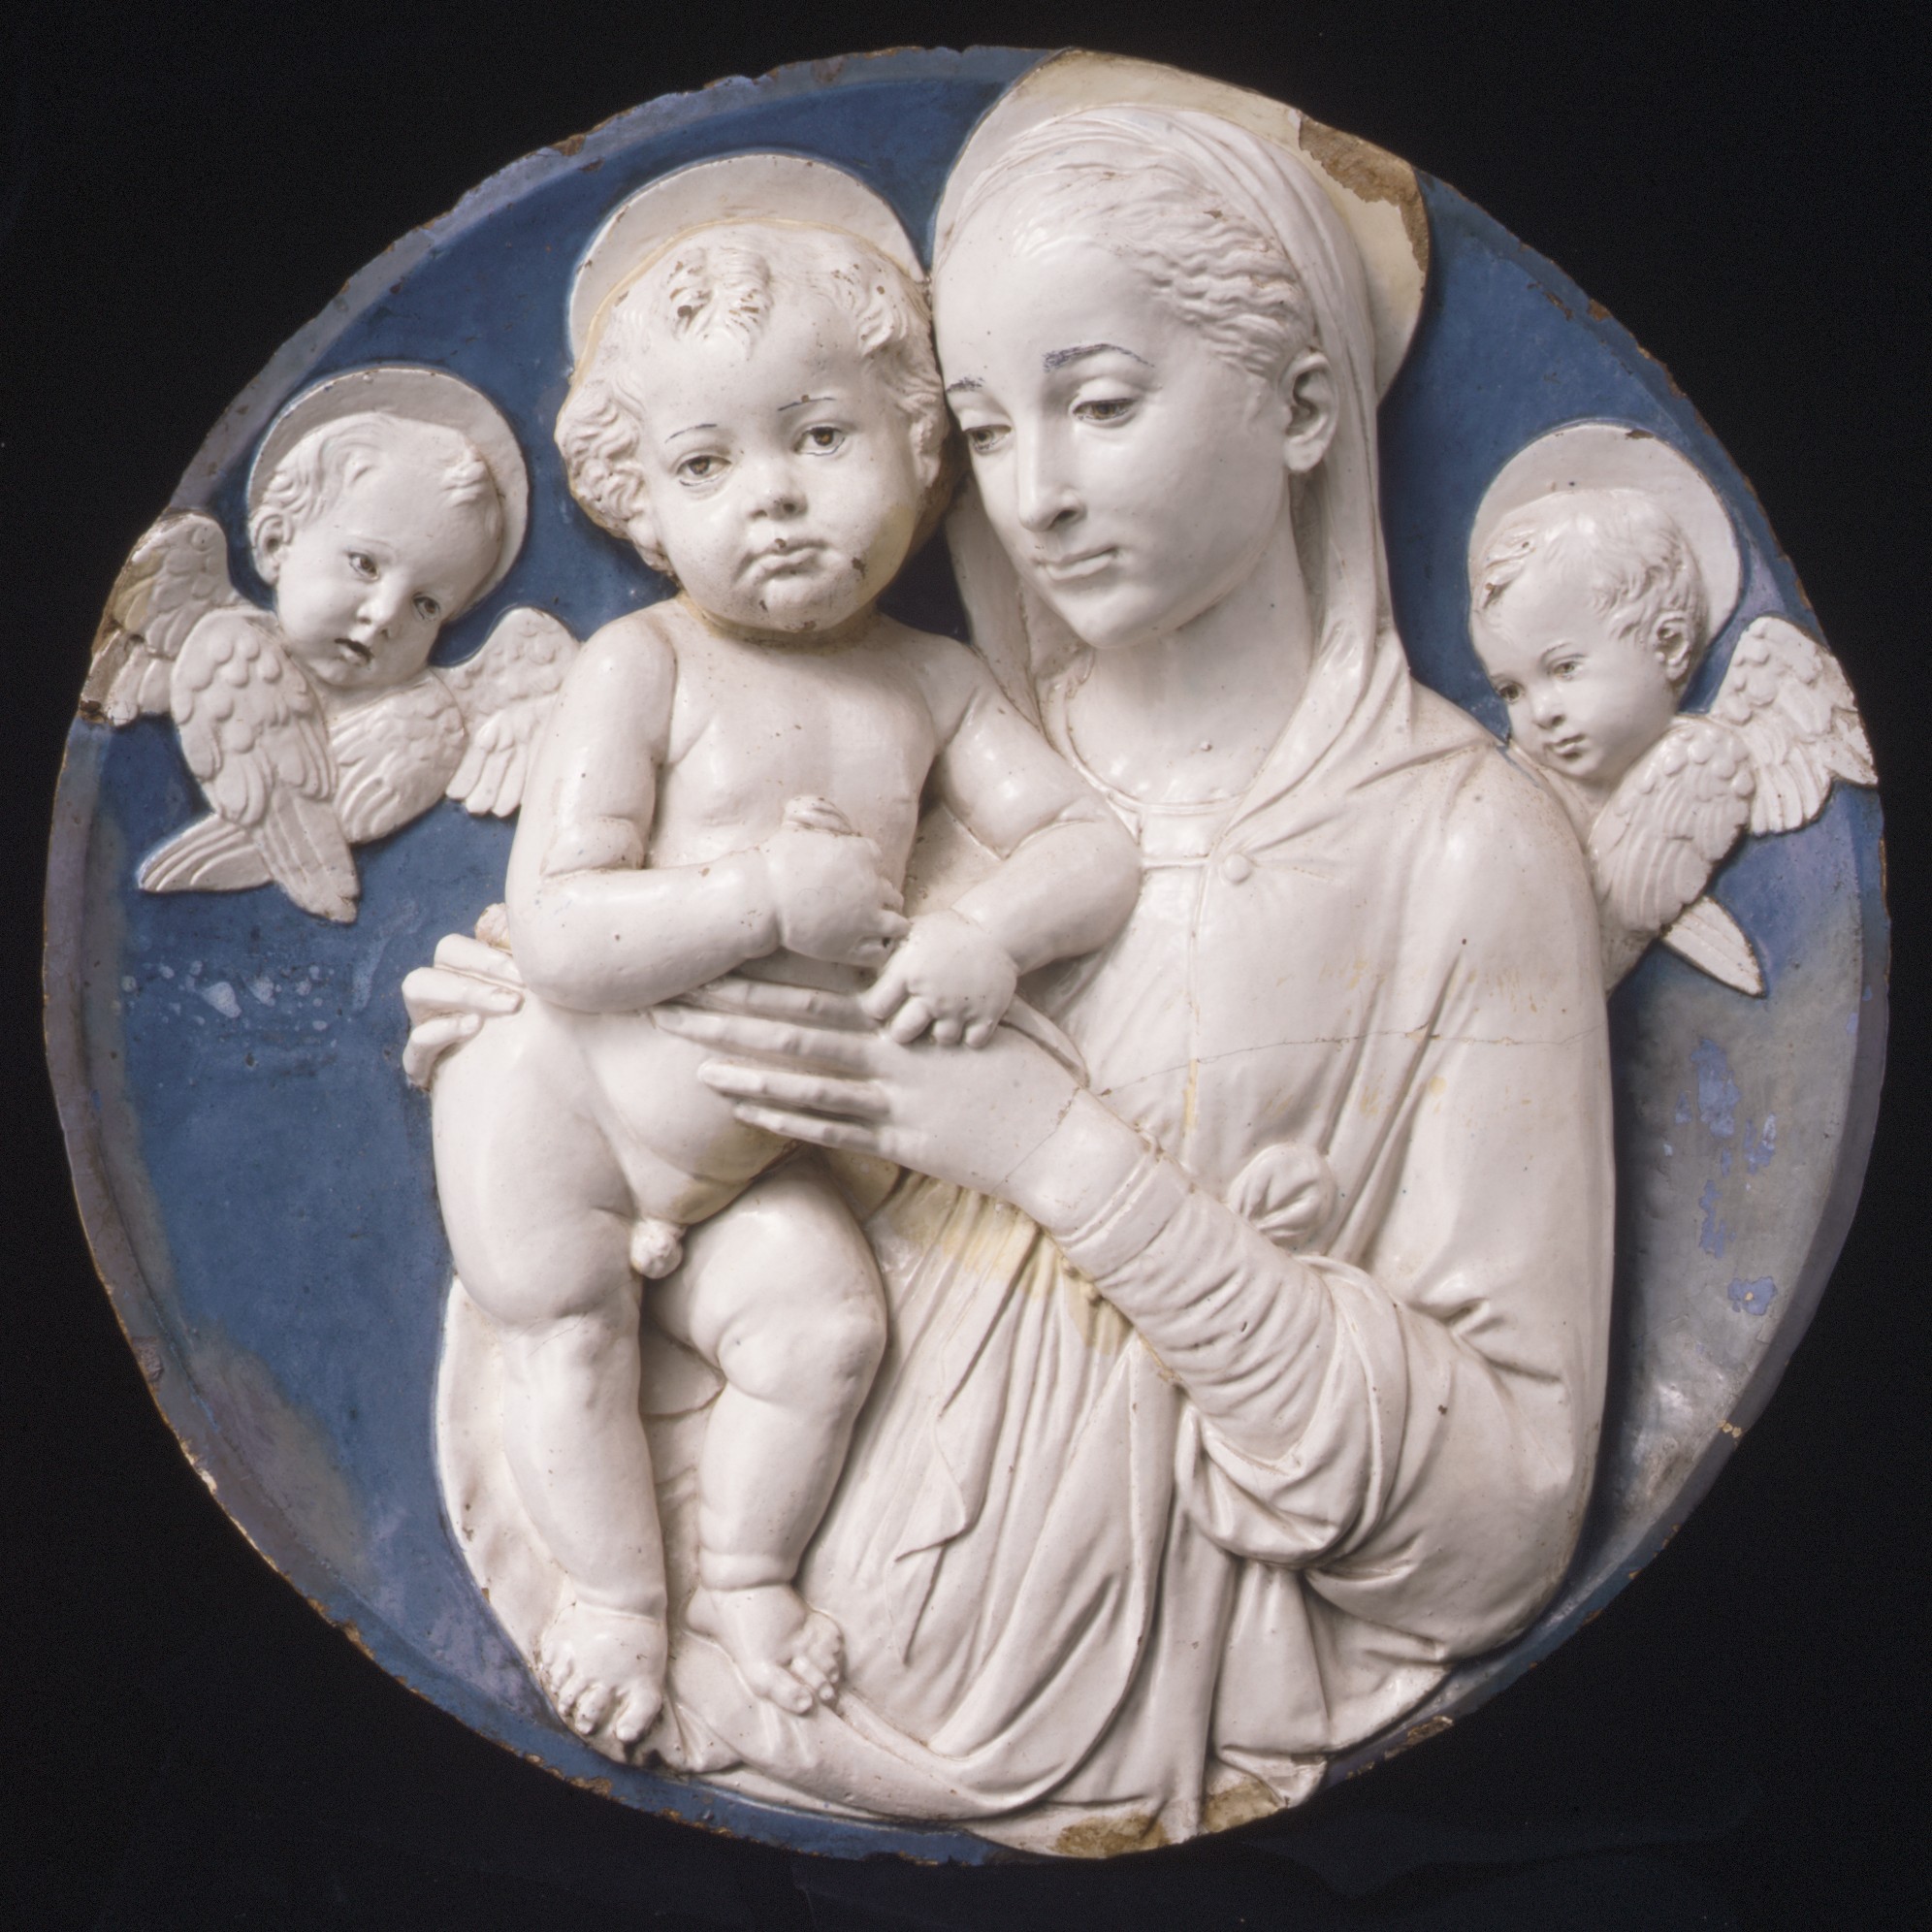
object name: tondo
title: Madonna and Child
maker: andrea della robbia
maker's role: artist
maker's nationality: italian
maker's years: 1435-1525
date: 1480-1490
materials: gilt, terracotta, wood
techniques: glazing, polychrome, relief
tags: angels,madonna and child